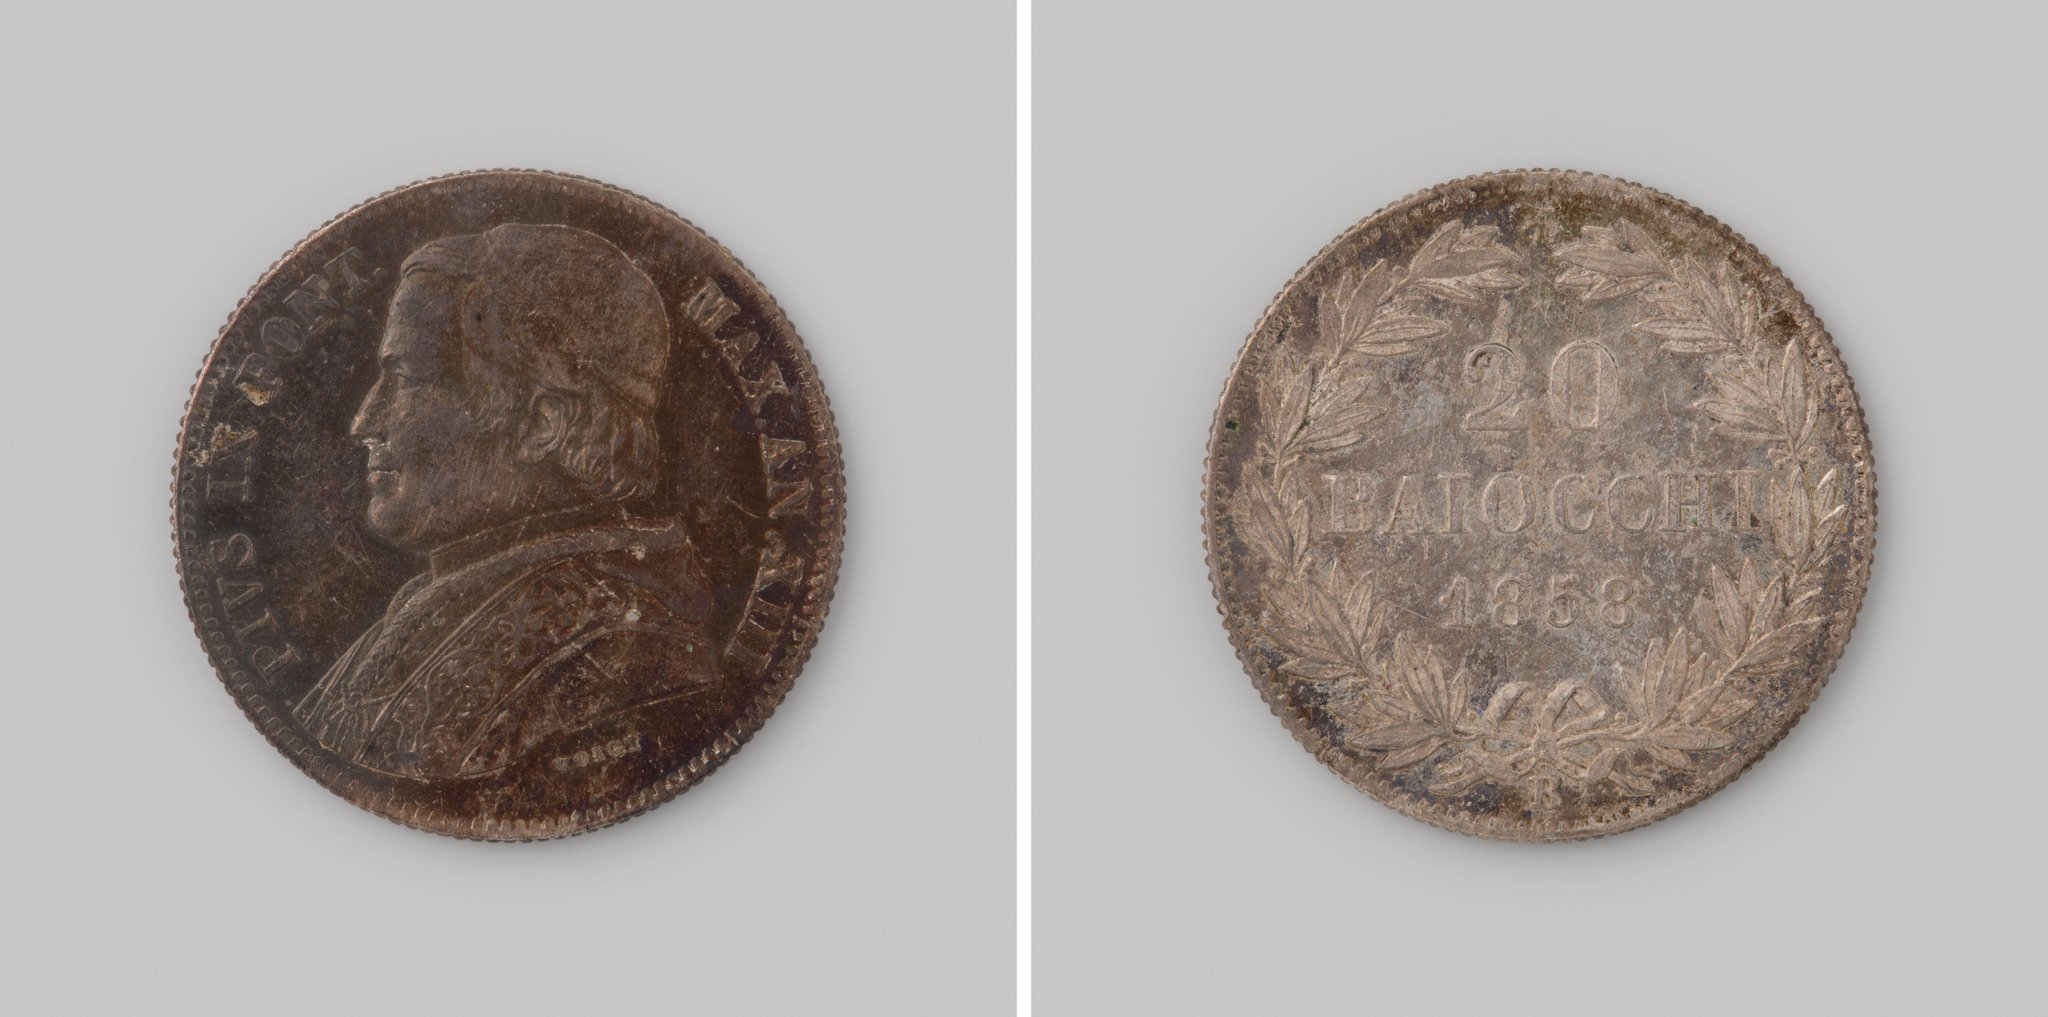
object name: coin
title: Kerkelijke Staat, paus Pius IX, 20 baiocchi, 1858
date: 1858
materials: silver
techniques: striking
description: Zilveren munt. Voorzijde: portret van de paus naar links. In omschrift jaartal: An XVIII = 1858. Keerzijde: binnen twee samengebonden takken waarde-aanduiding in twee regels, waaronder jaartal. Onderaan letter B. Kartelrand.